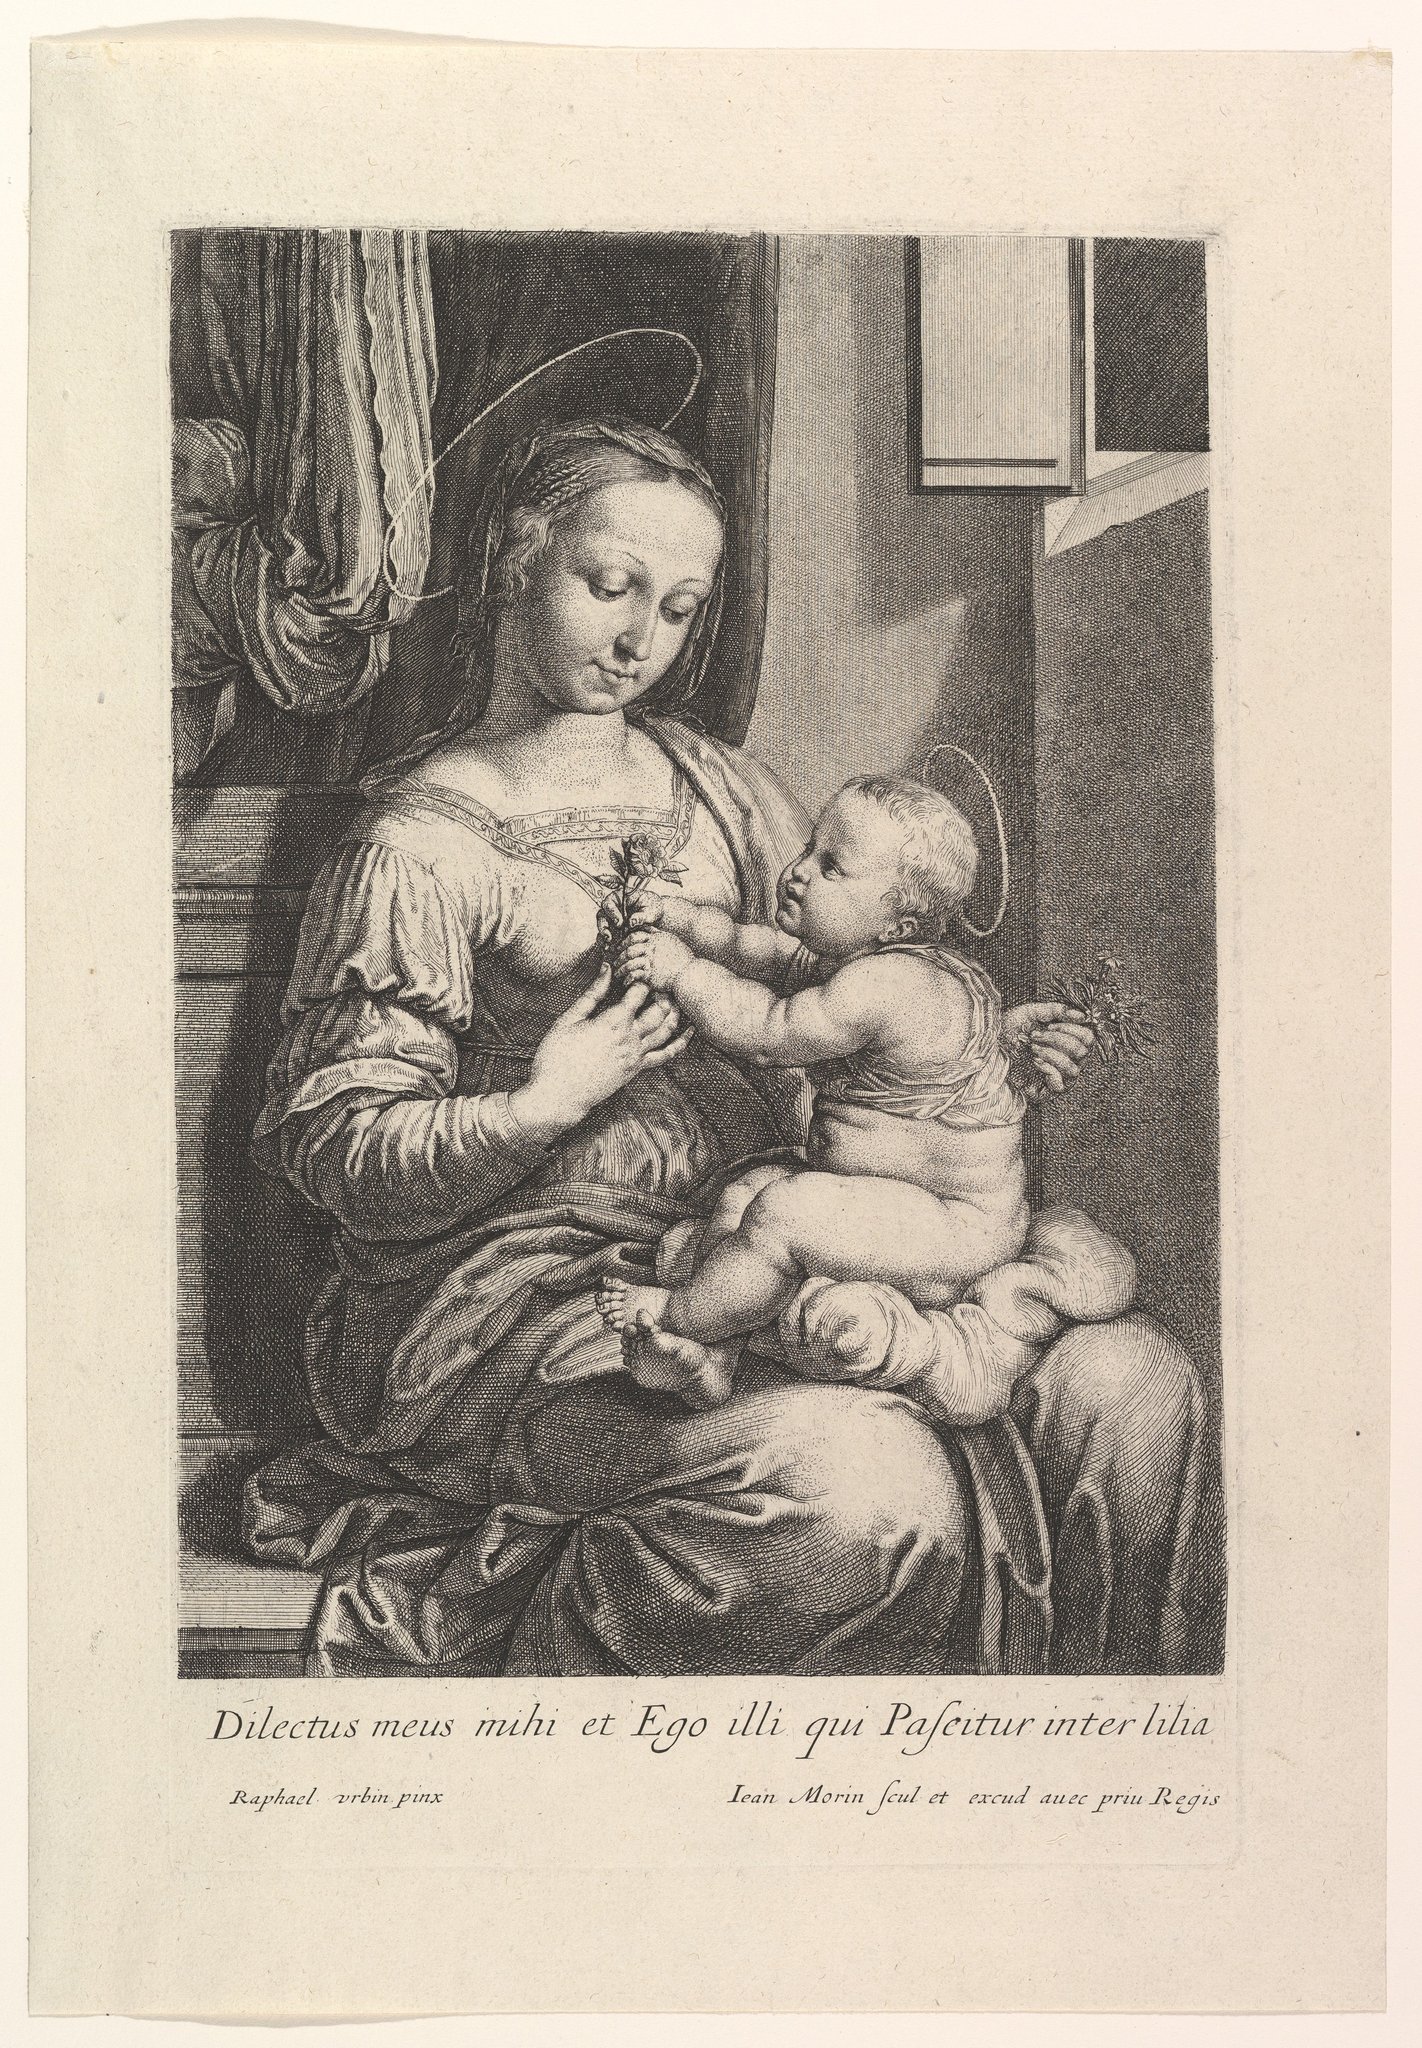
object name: print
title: La Vierge a l'enfant, a la rose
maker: jean morin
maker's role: artist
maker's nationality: french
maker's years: 1605-1650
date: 1605-1650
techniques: etching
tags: flowers,madonna and child